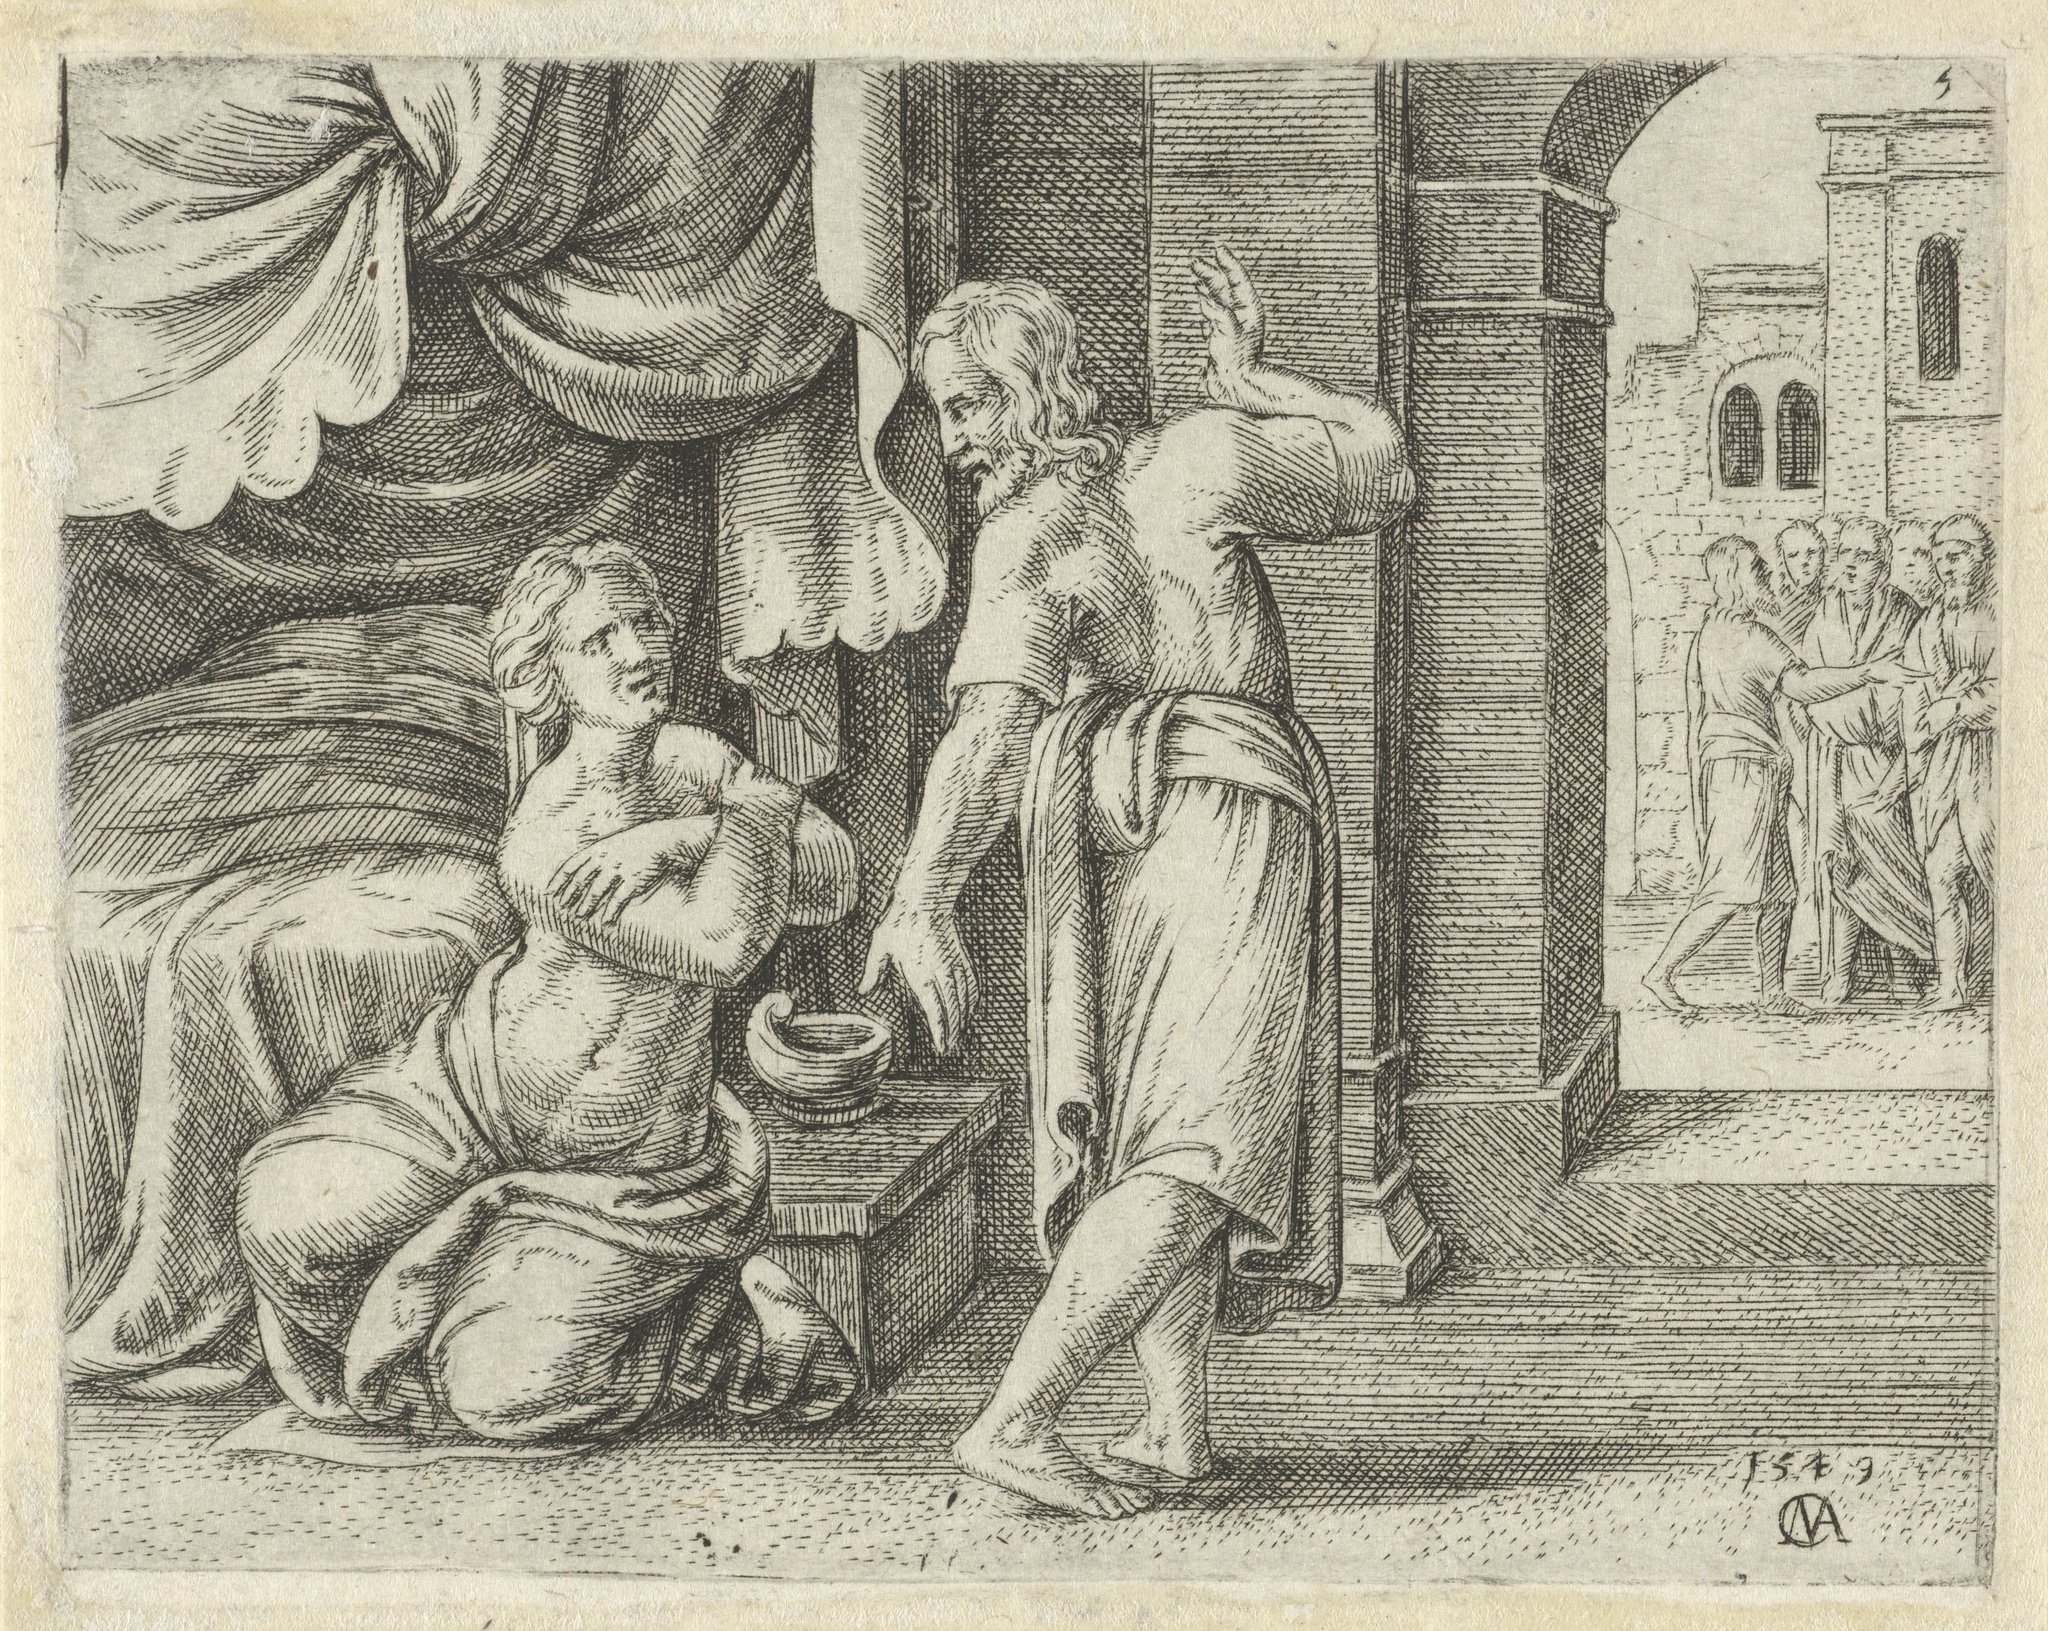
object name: print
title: Geschiedenis van Simson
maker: cornelis massijs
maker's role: painter, print maker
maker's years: 1510-1557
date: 1549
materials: paper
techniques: engraving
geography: antwerp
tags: samson, tired of her weeping, tells his wife the solution of the riddle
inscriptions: collector's mark: Lugt 2228, collector's mark: Lugt 2542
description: De Filistijnse vrouw zit geknield naast een bed en smeekt Simson om haar de oplossing van zijn raadsel te verklappen. Moe van haar gehuil vertelt Simson haar de oplossing, waarna zij het aan de bruiloftsgasten zal vertellen. Rechtsachter overleggen de gasten met elkaar wat de oplossing van het raadsel zou kunnen zijn.